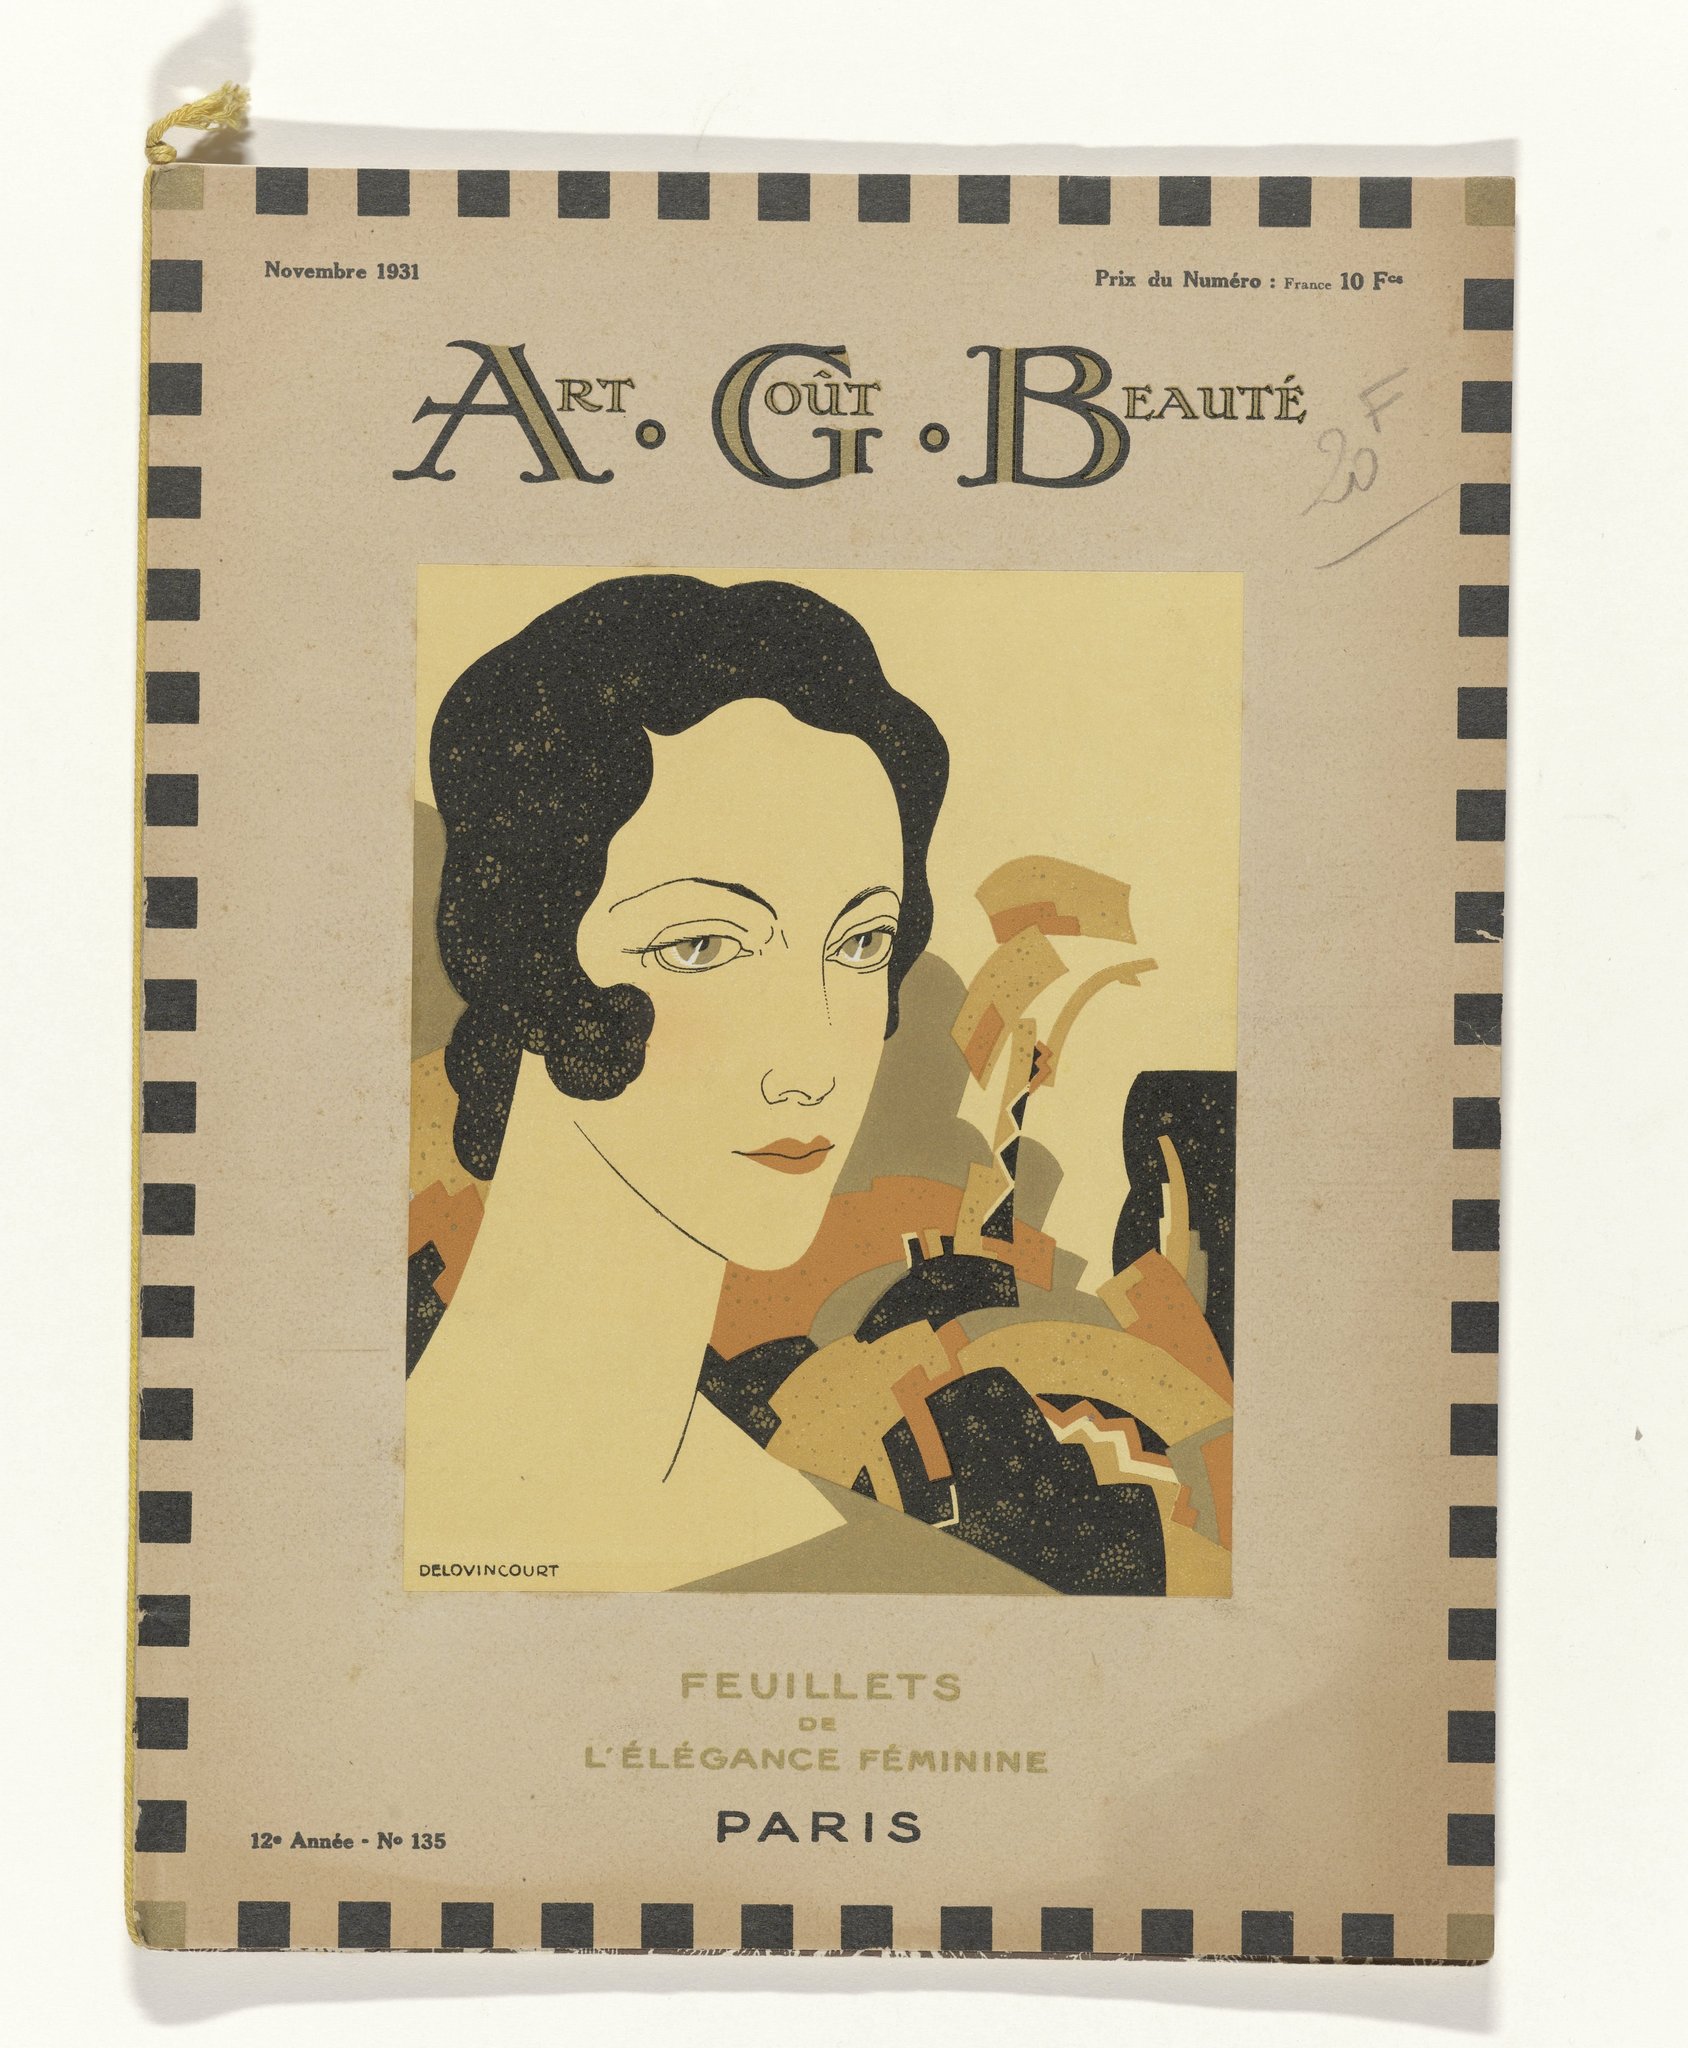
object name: magazine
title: Art - Goût - Beauté, Feuillets de l' élégance féminine, Novembre 1931, No. 135, 12e Année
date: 1931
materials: paper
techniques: brush, hand coloring, lithograph, pochoir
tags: fashion plates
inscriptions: title: ‘ART. GOÛT. BEAUTÉ’, title: ‘FEUILLETS DE L'ÉlÉGANCE FÉMININE / PARIS’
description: Omslag van het modetijdschrift Art-Goût-Beauté (1920-1933), november 1931, No. 135. Afbeelding van een vrouwenhoofd, waarachter een geometrisch motief.